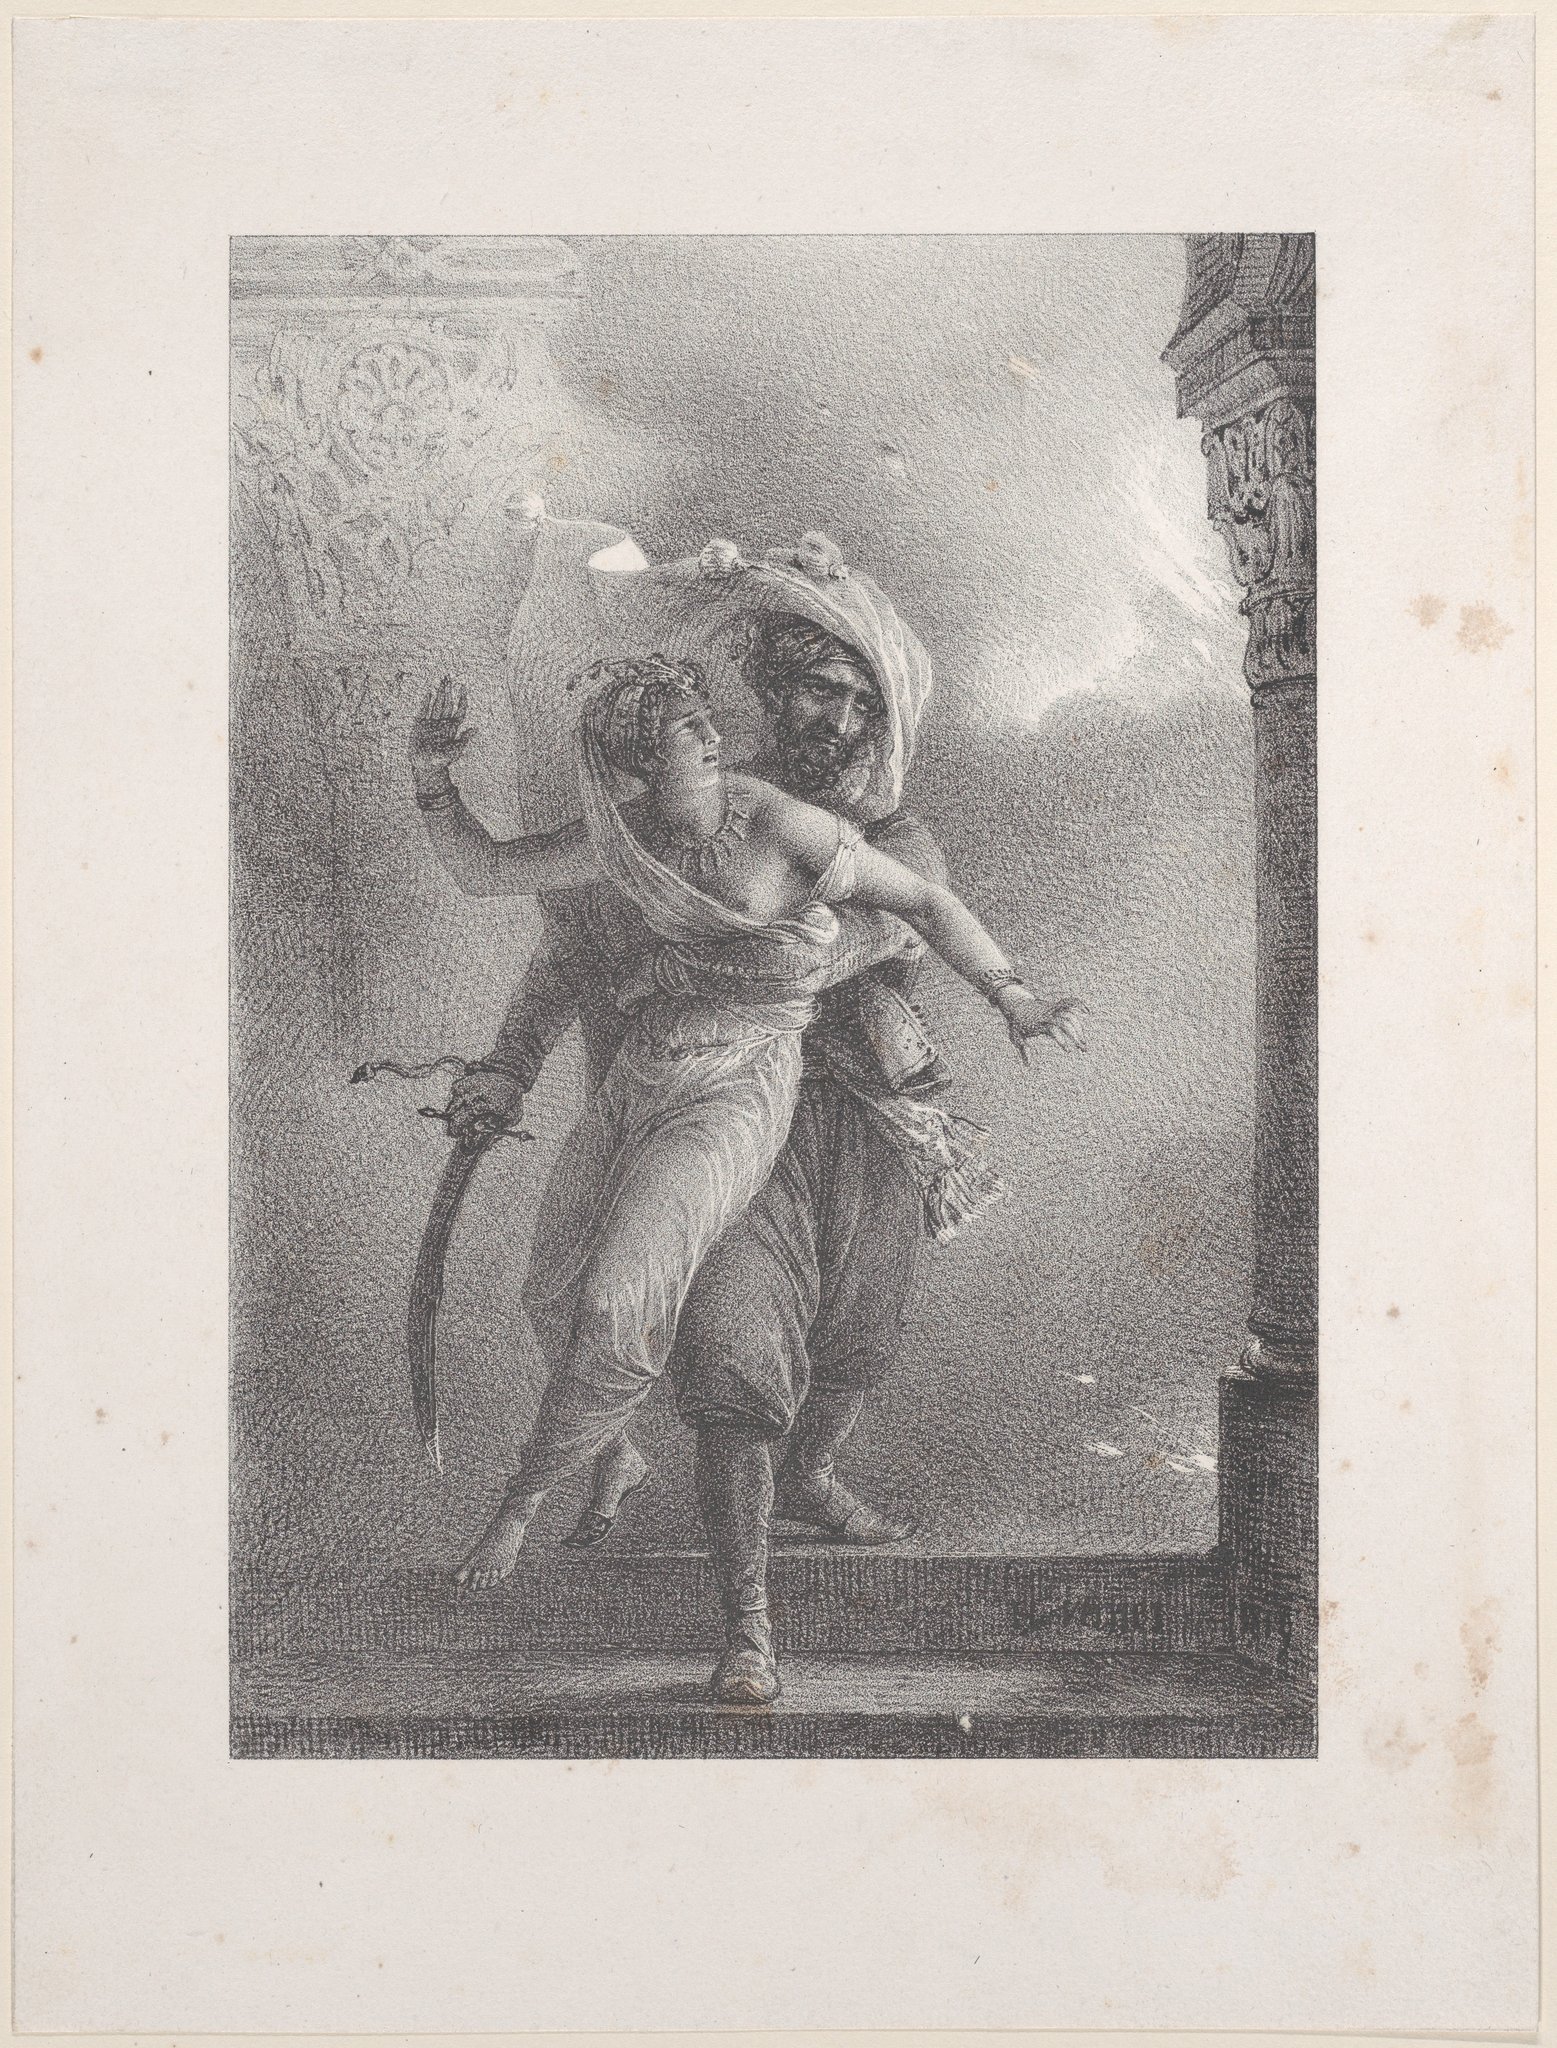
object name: print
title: Conrad Saving Gulnare from the Fire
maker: horace vernet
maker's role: artist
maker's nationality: french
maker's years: 1789-1863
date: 1820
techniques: lithograph